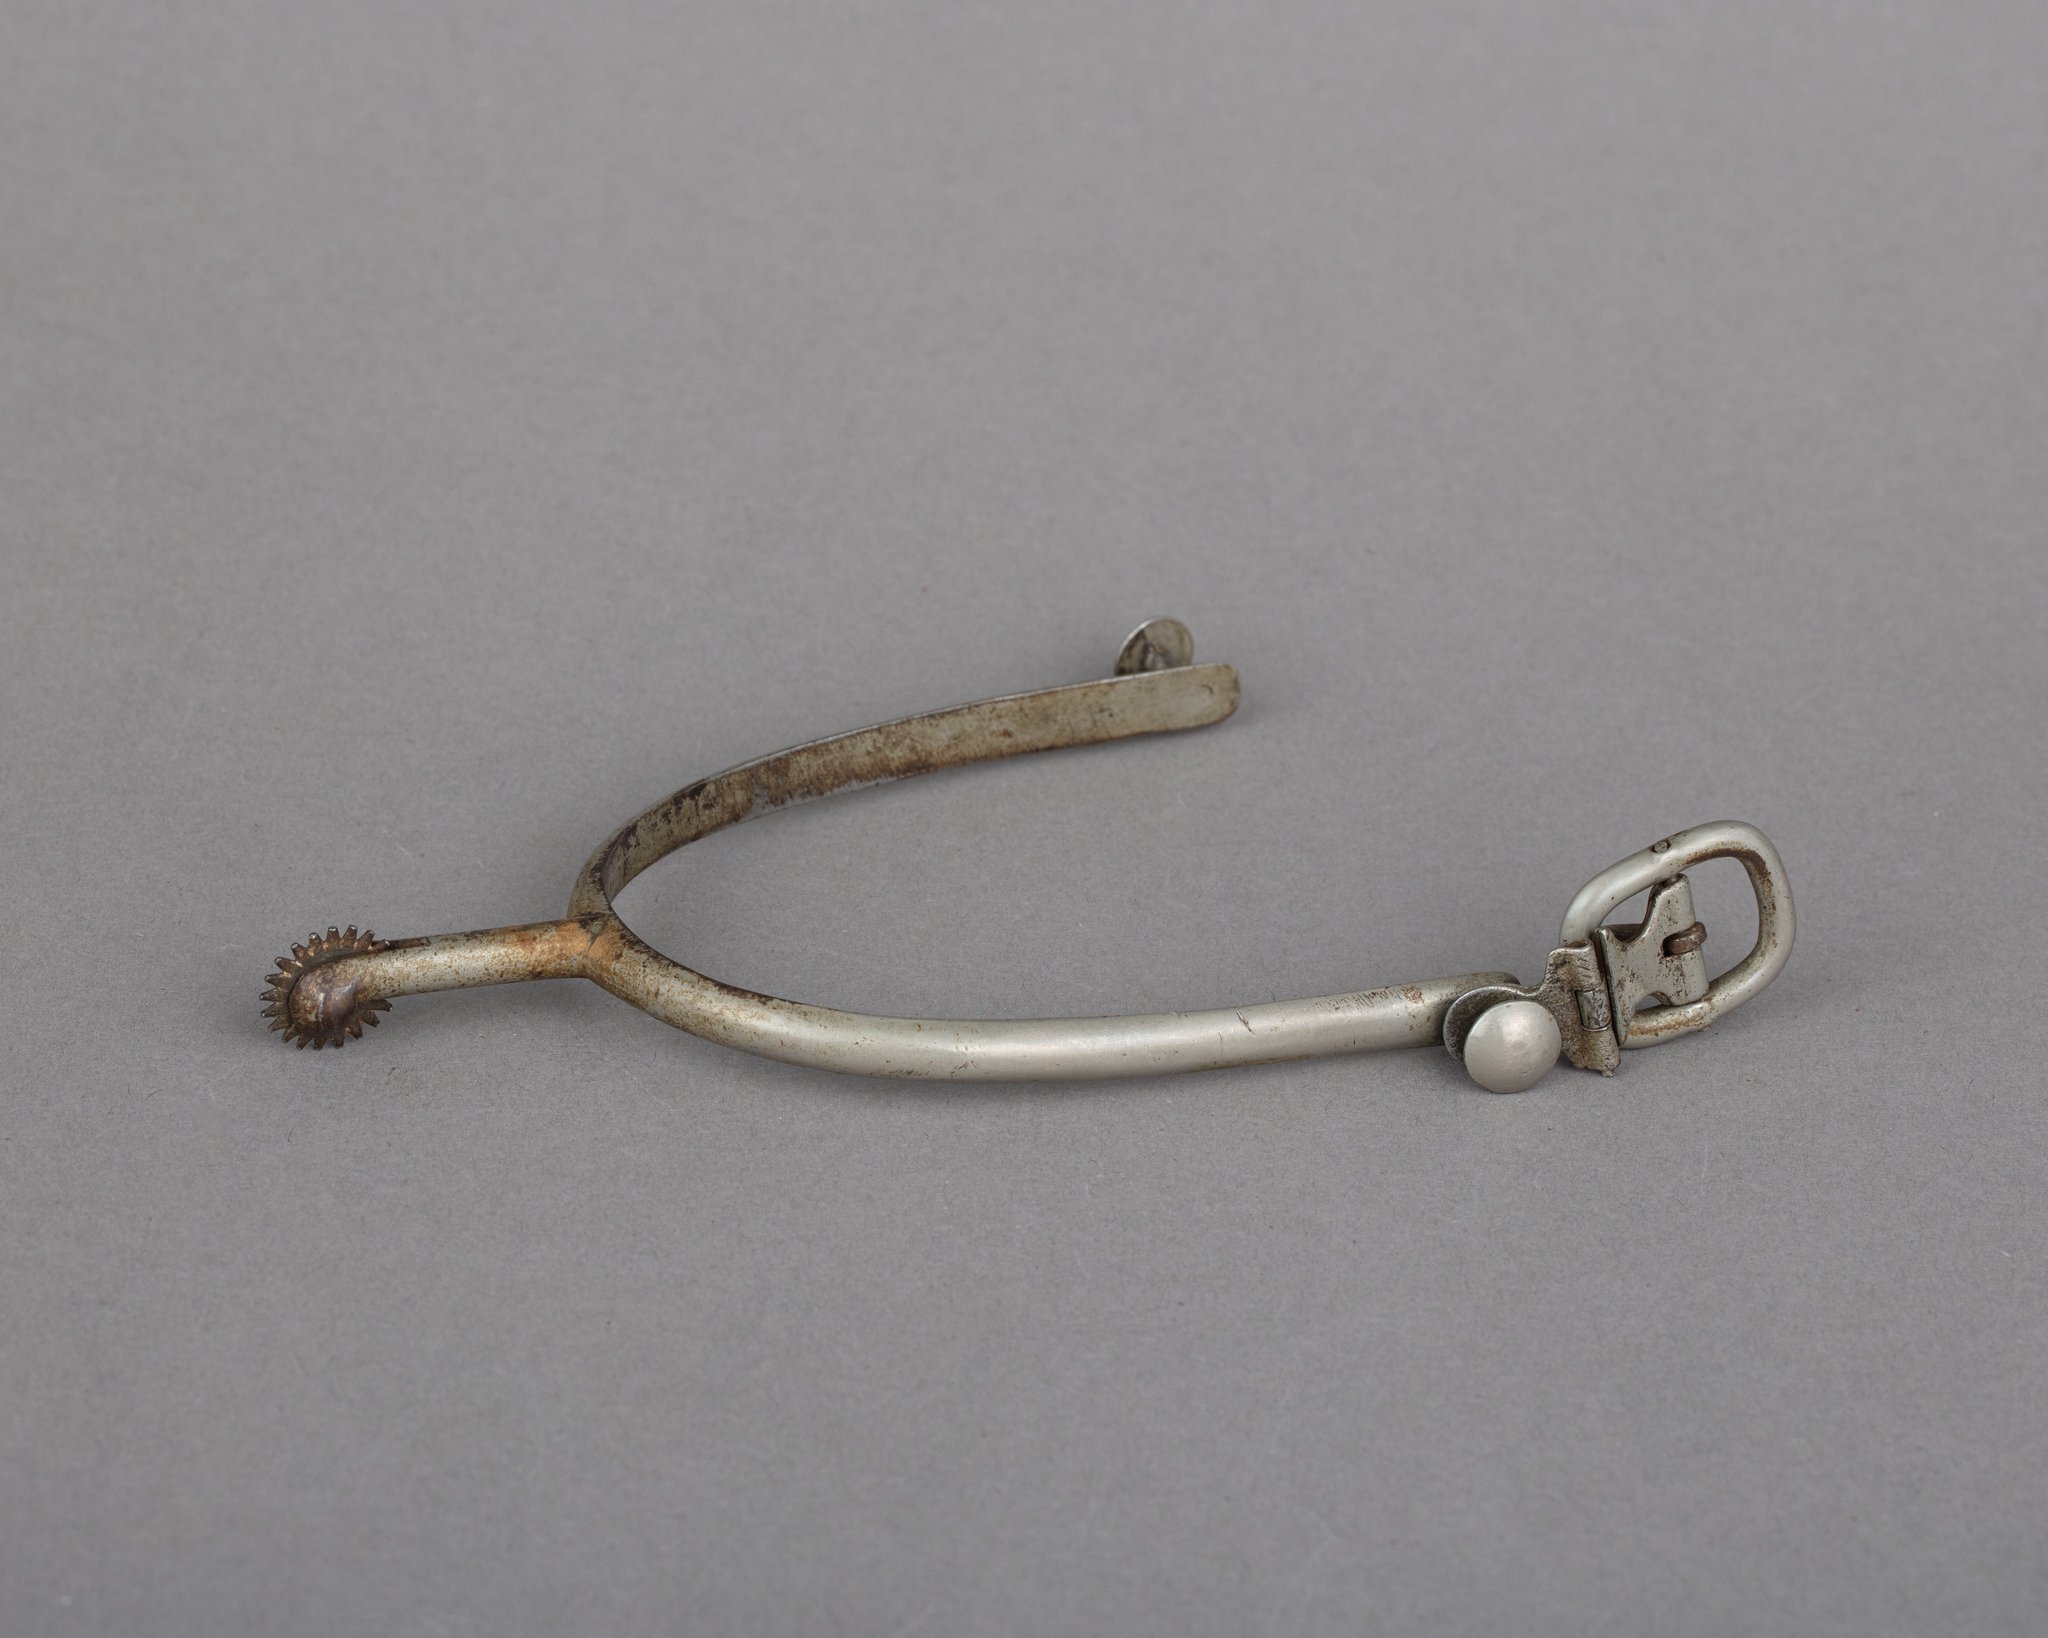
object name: spur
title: Rowel Spur (Right)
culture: american or english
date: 1867-1900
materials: metal alloy, nickel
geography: united kingdom